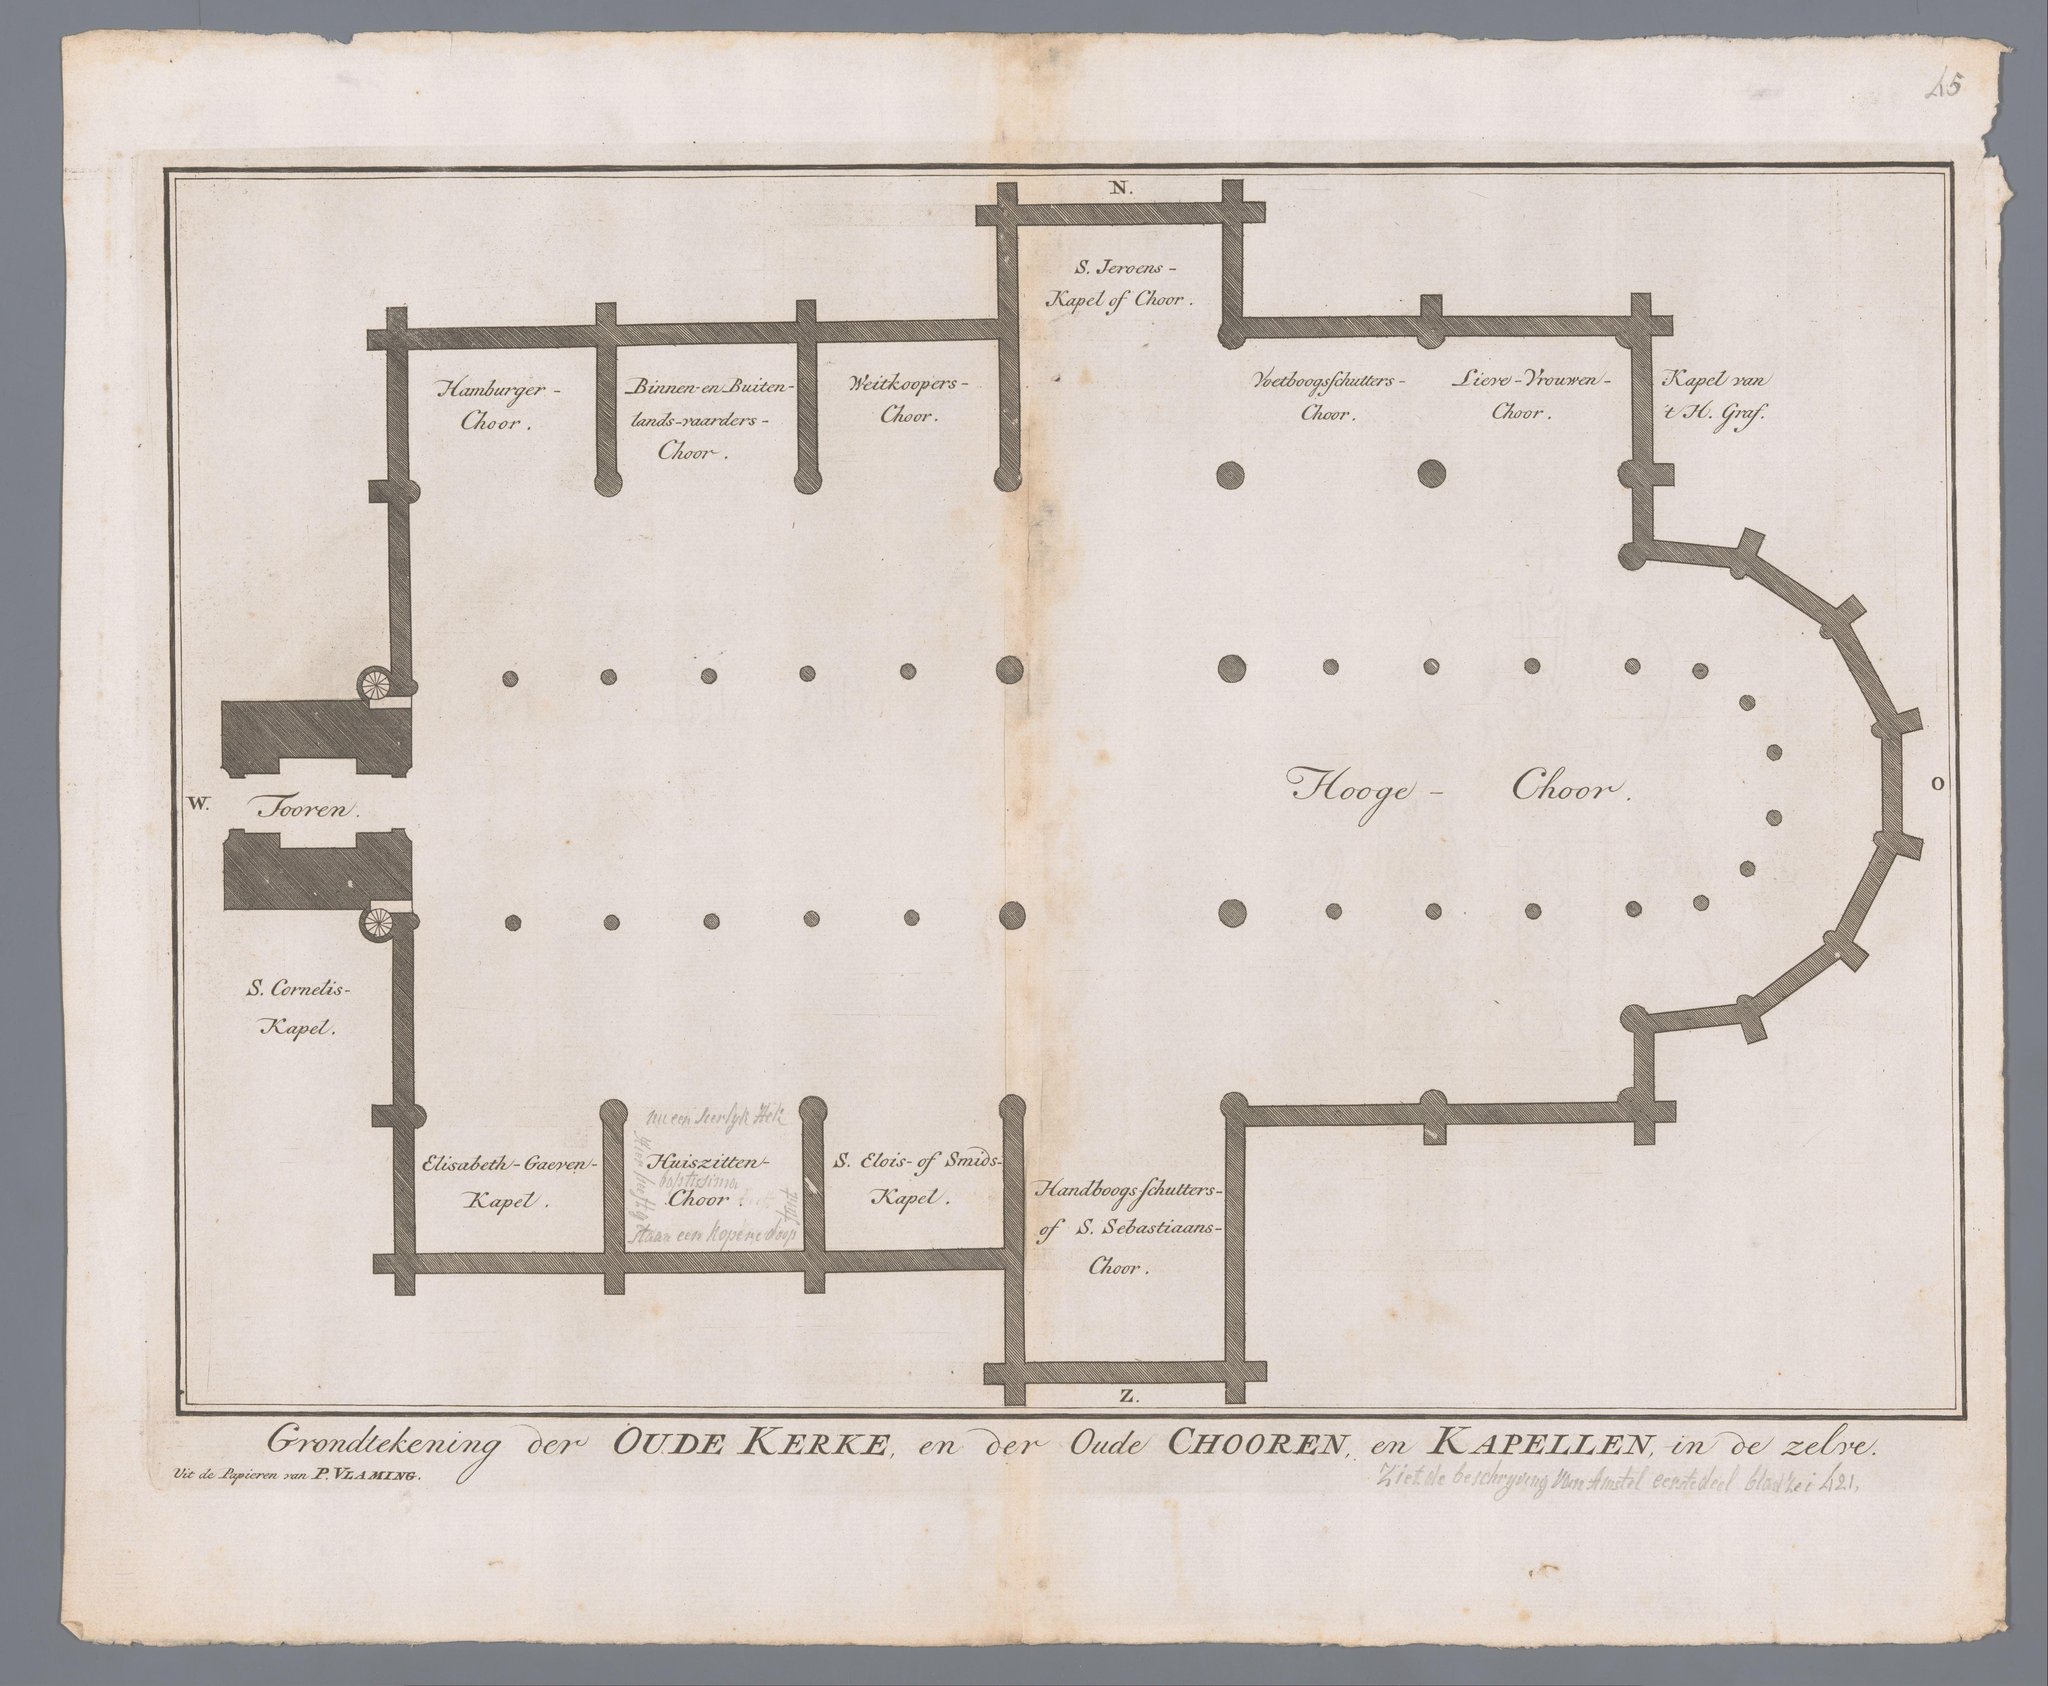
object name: area plan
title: Grondtekening der Oude Kerke, en der Oude Chooren, en Kapellen, in de zelve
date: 1765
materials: paper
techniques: etching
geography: amsterdam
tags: interior of church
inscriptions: inscription: ‘Baptissima Hier heeft op gestaan een kopere doopfont nu een sierlijk [...]’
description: Prent uit: Wagenaar, Jan. Amsterdam, in zyne opkomst, aanwas, geschiedenissen (…). Amsterdam: Isaak Tirion, 1765, dl. 2, tussen p. 98 en 99.